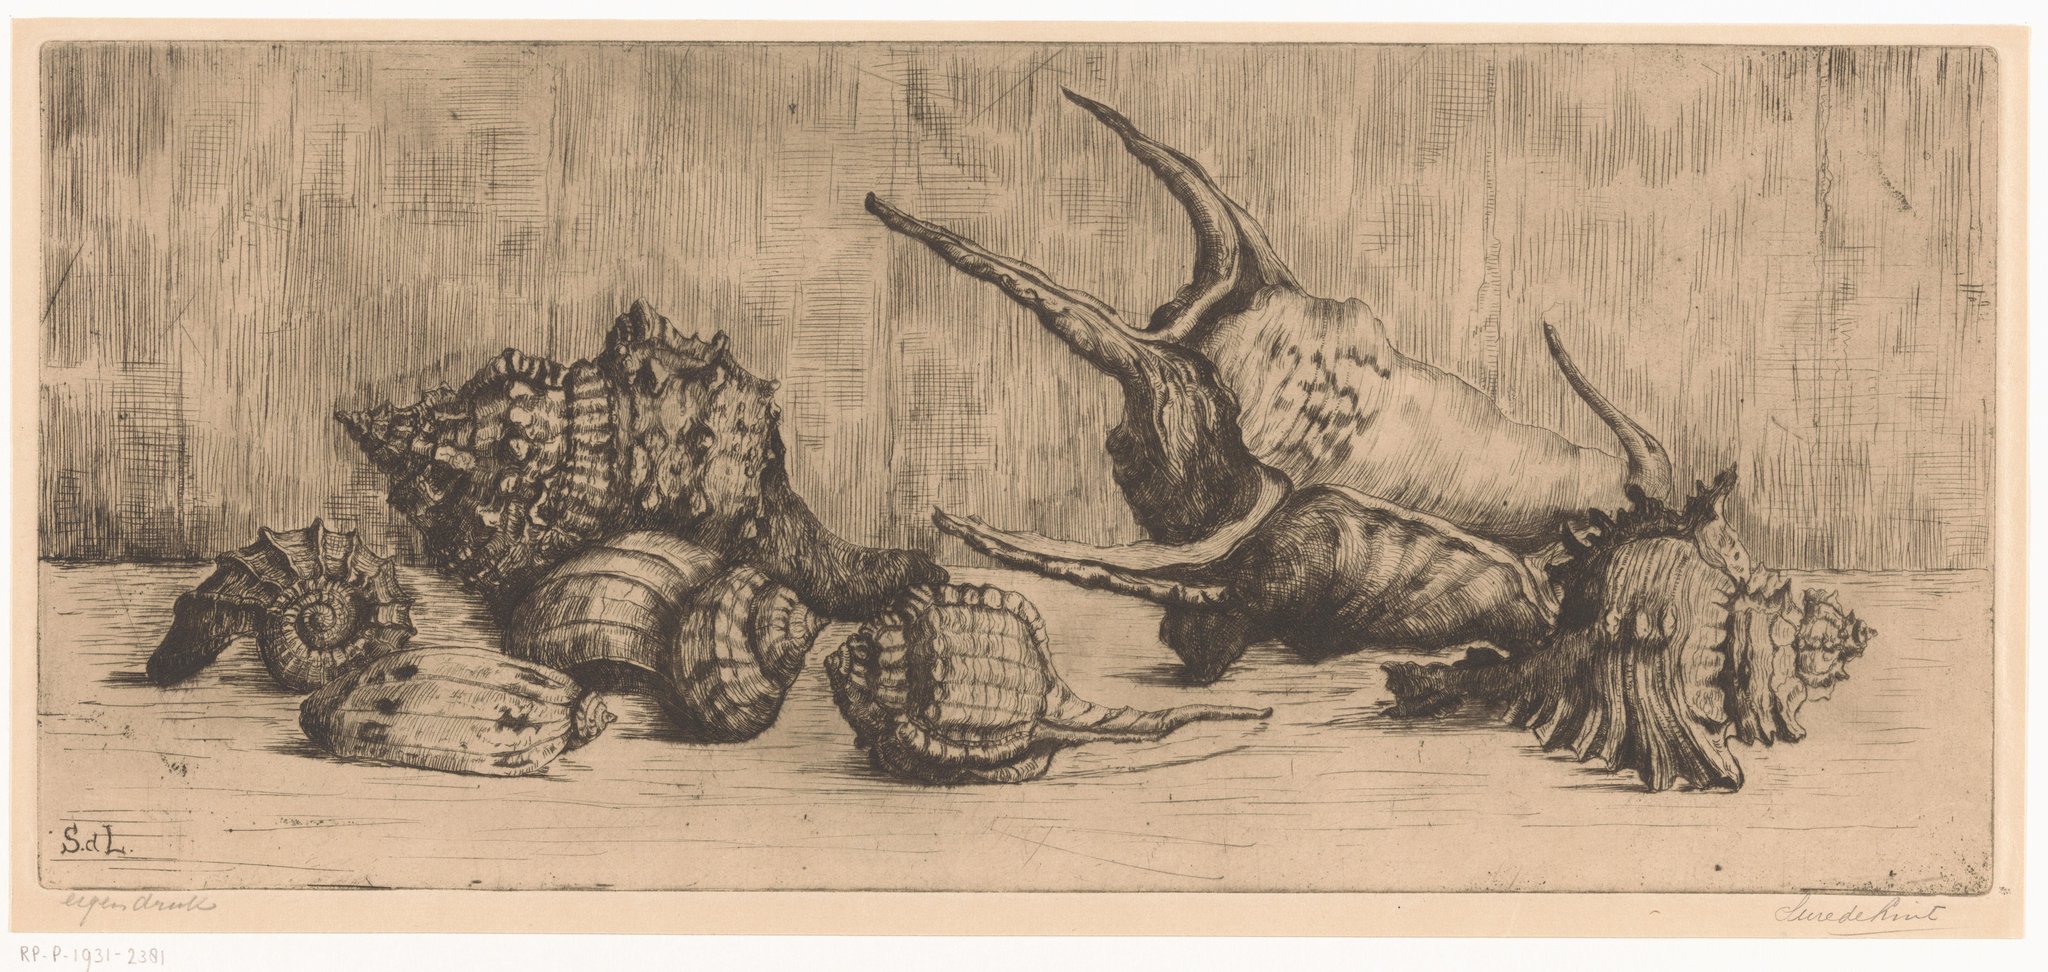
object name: print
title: Schelpen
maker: suze de lint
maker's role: print maker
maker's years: 1878-1953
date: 1888-1931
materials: paper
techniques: etching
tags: molluscs (+ shell, snail-shell etc.)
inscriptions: collector's mark: Lugt 2228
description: Zeven schelpen, waaronder een koninginneschelp.